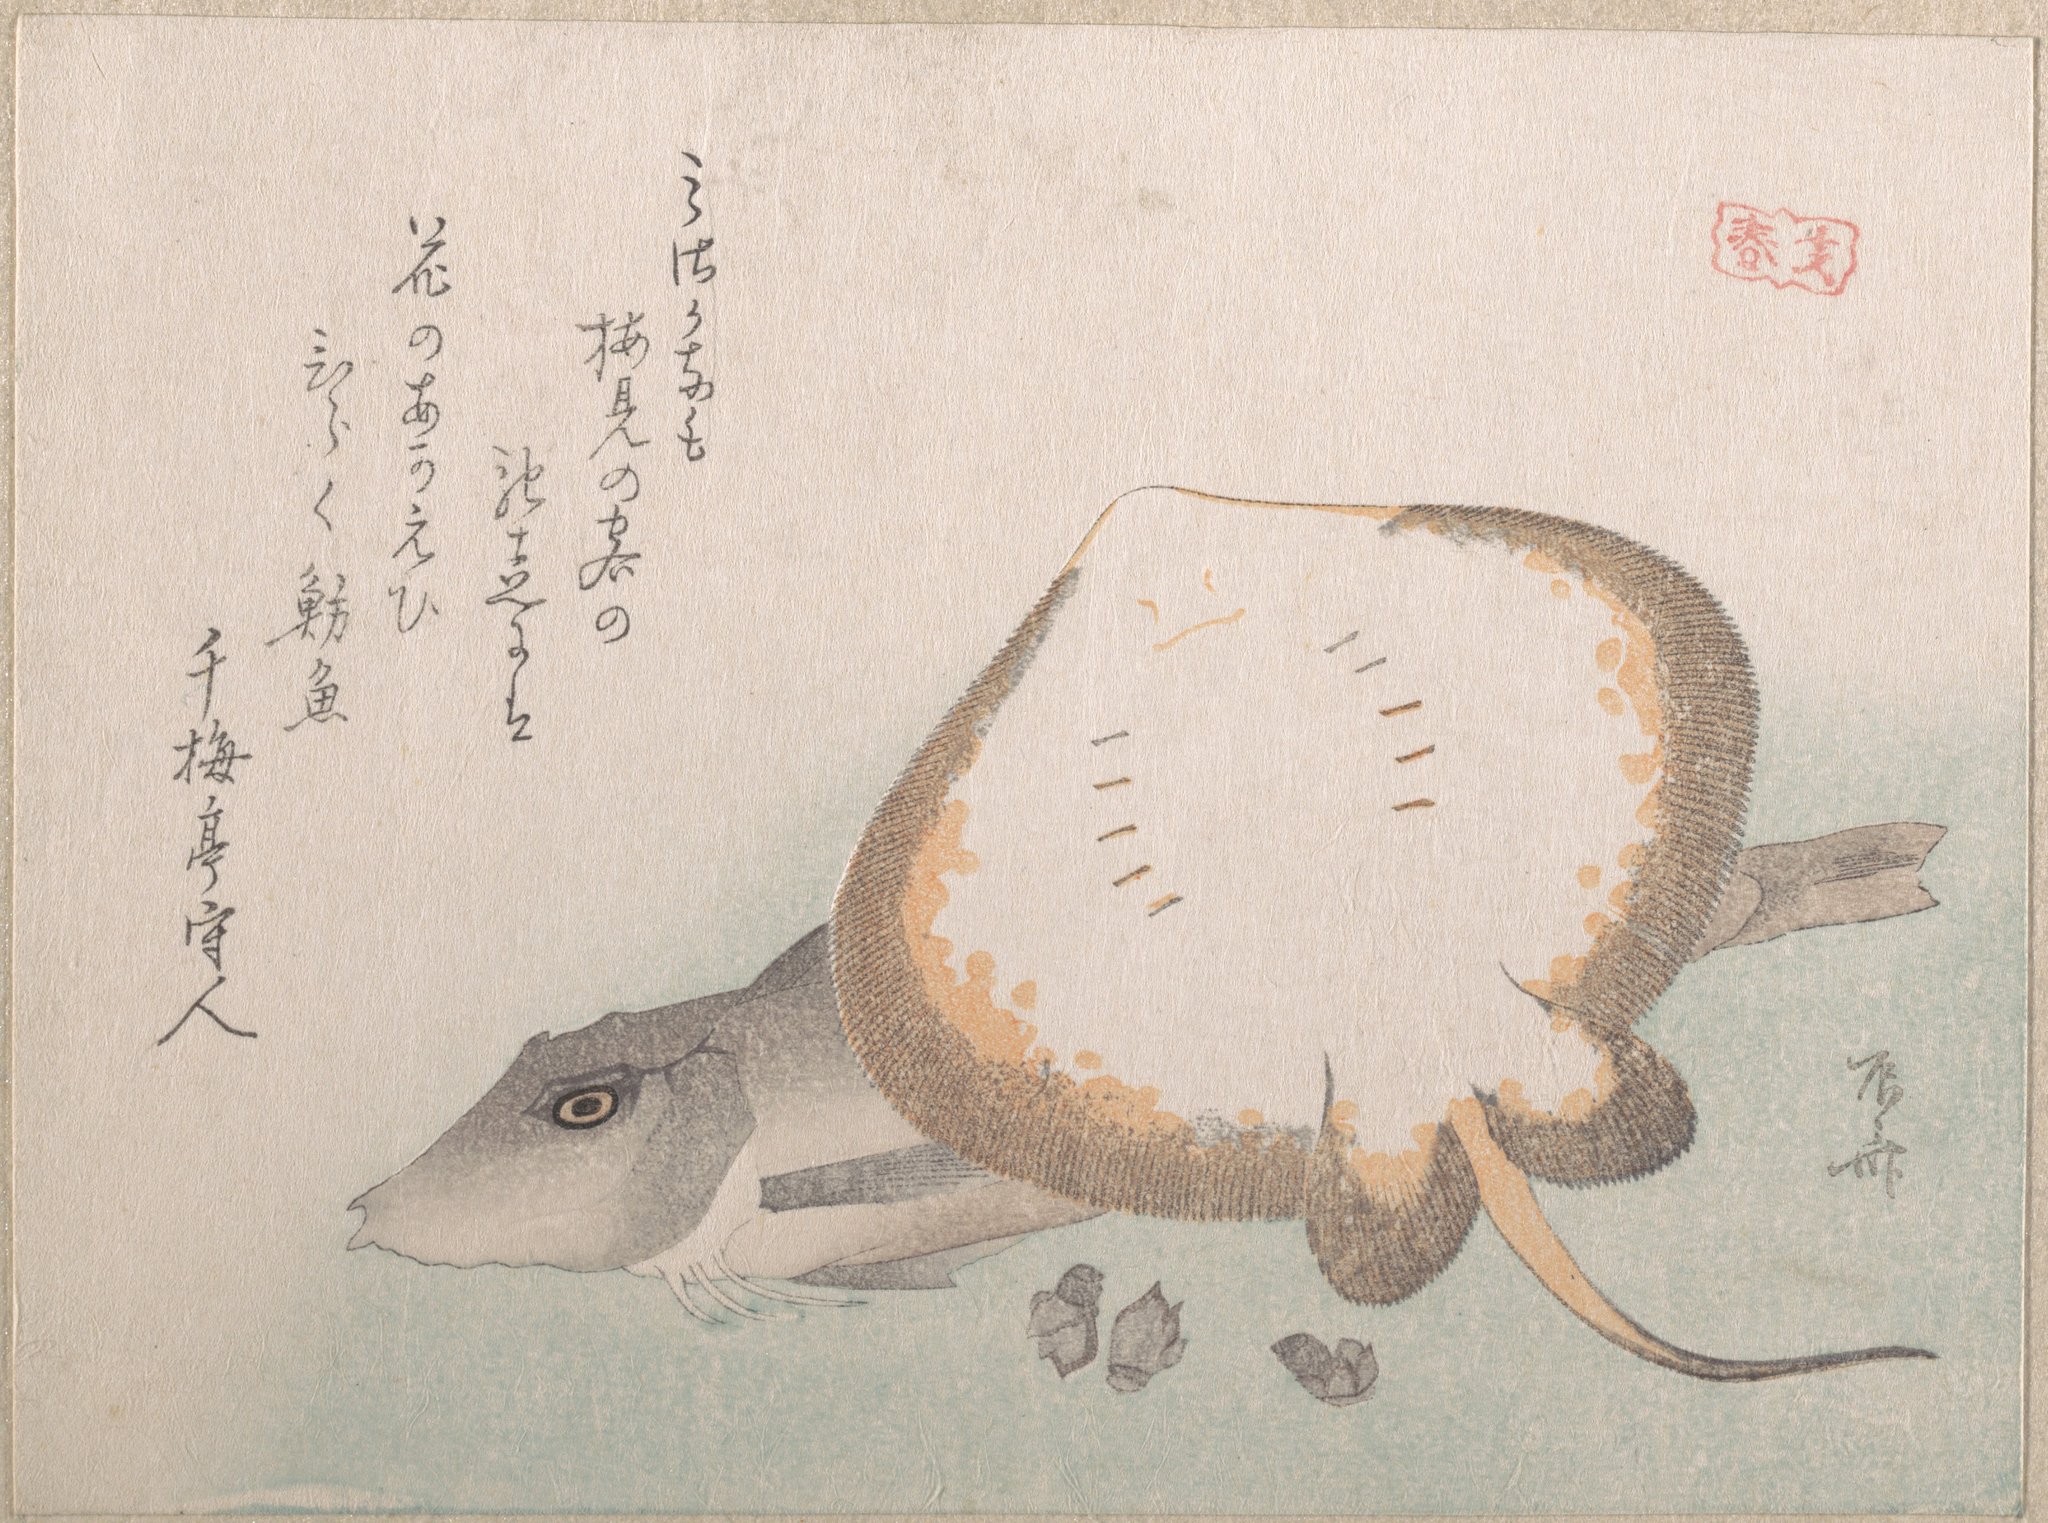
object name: print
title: Stingray and Gurnard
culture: japanese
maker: ryūryūkyo shinsai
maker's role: artist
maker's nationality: japanese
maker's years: 1799-1823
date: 1815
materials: ink, paper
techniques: surimono, woodblock print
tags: fish